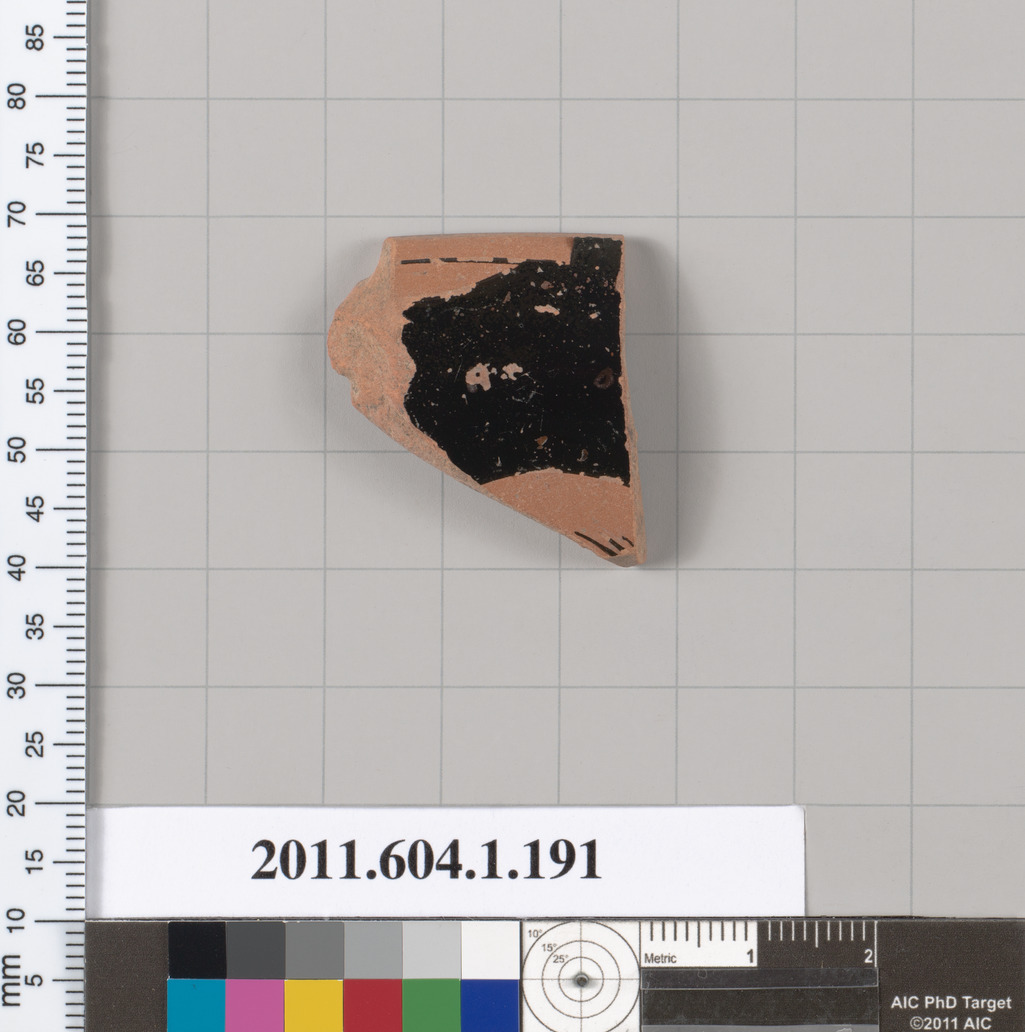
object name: kylix fragment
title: Terracotta rim fragment of a kylix (drinking cup)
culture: greek, attic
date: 475-451 BCE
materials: terracotta